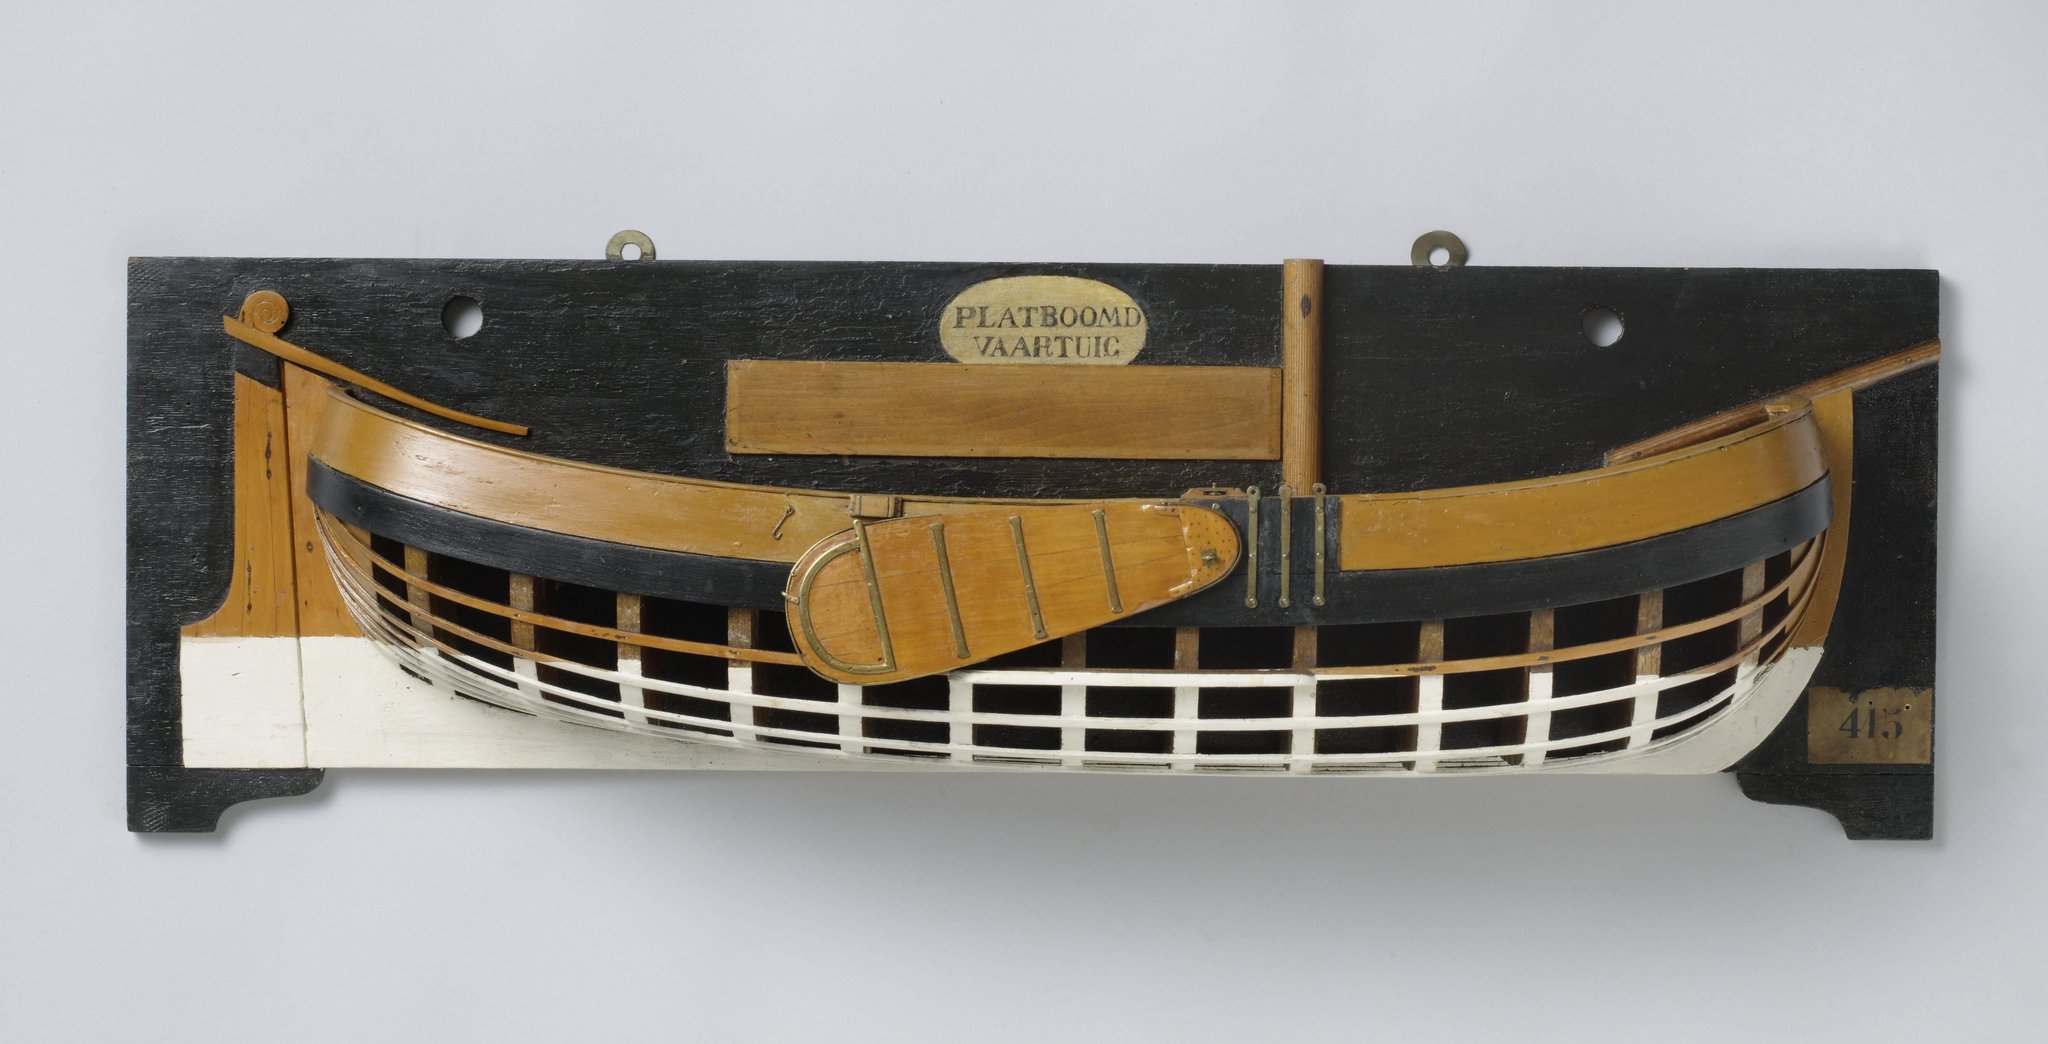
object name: ship model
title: Half model of a gaff-rigged gunboat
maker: Anonymous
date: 1780-1830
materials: wood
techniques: polychromy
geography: netherlands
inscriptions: scale, top centre: paper scale (missing), label, bottom right: ‘415’ former inventory label, inscription, top centre, on an oval white label: ‘PLATBOOMD VAARTUIG’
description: Gepolychromeerd mallenmodel (stuurboord) van een eenmaster. De huid boven het barkhout is gesloten en gedetailleerd met een zwaard en drie puttings; één geschutpoort in de boeg. Het dek is gesloten. Rond achterschip, breed roer. Platbodem. De zeeg loopt naar voren en achter op, één barkhout.